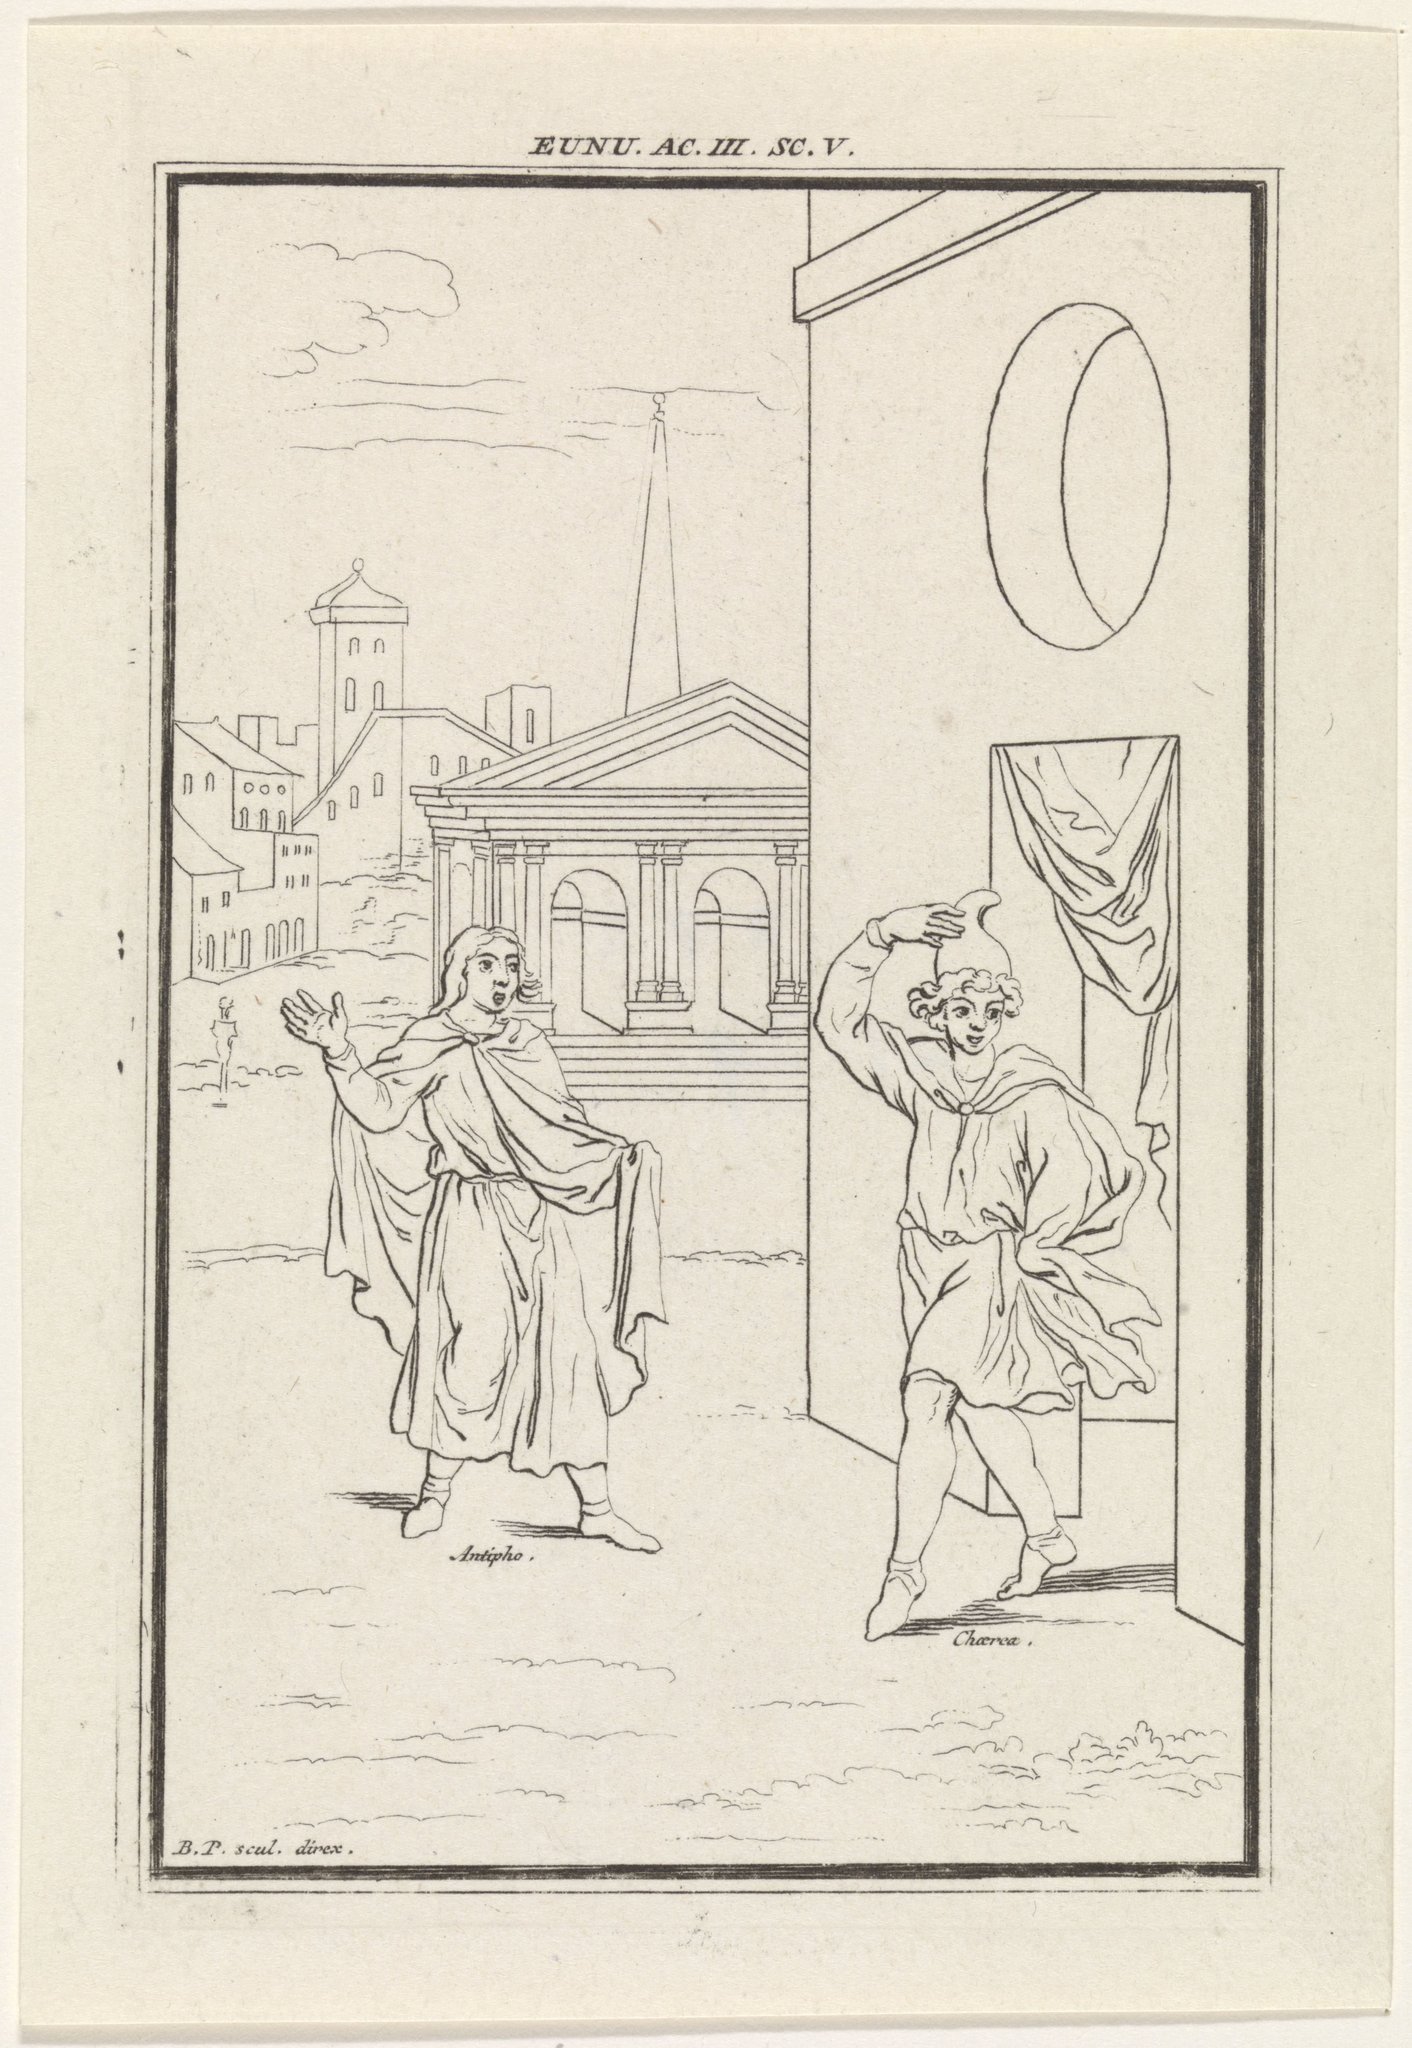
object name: book illustration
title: Scène uit de komedie Eunuchus van Terentius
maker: bernard picart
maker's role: draughtsman, print maker, publisher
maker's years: 1673-1733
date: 1716-1718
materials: paper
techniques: engraving, etching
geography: amsterdam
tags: specific works of literature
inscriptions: collector's mark: Lugt 2233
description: Prent ook gebruikt als illustratie in: Terentius, Publius. Les comedies de Terence: avec la traduction et les remarques, deel I, na p. 382. [Geannoteerd door] Anne Dacier. Rotterdam: Caspar Fritsch, 1717.